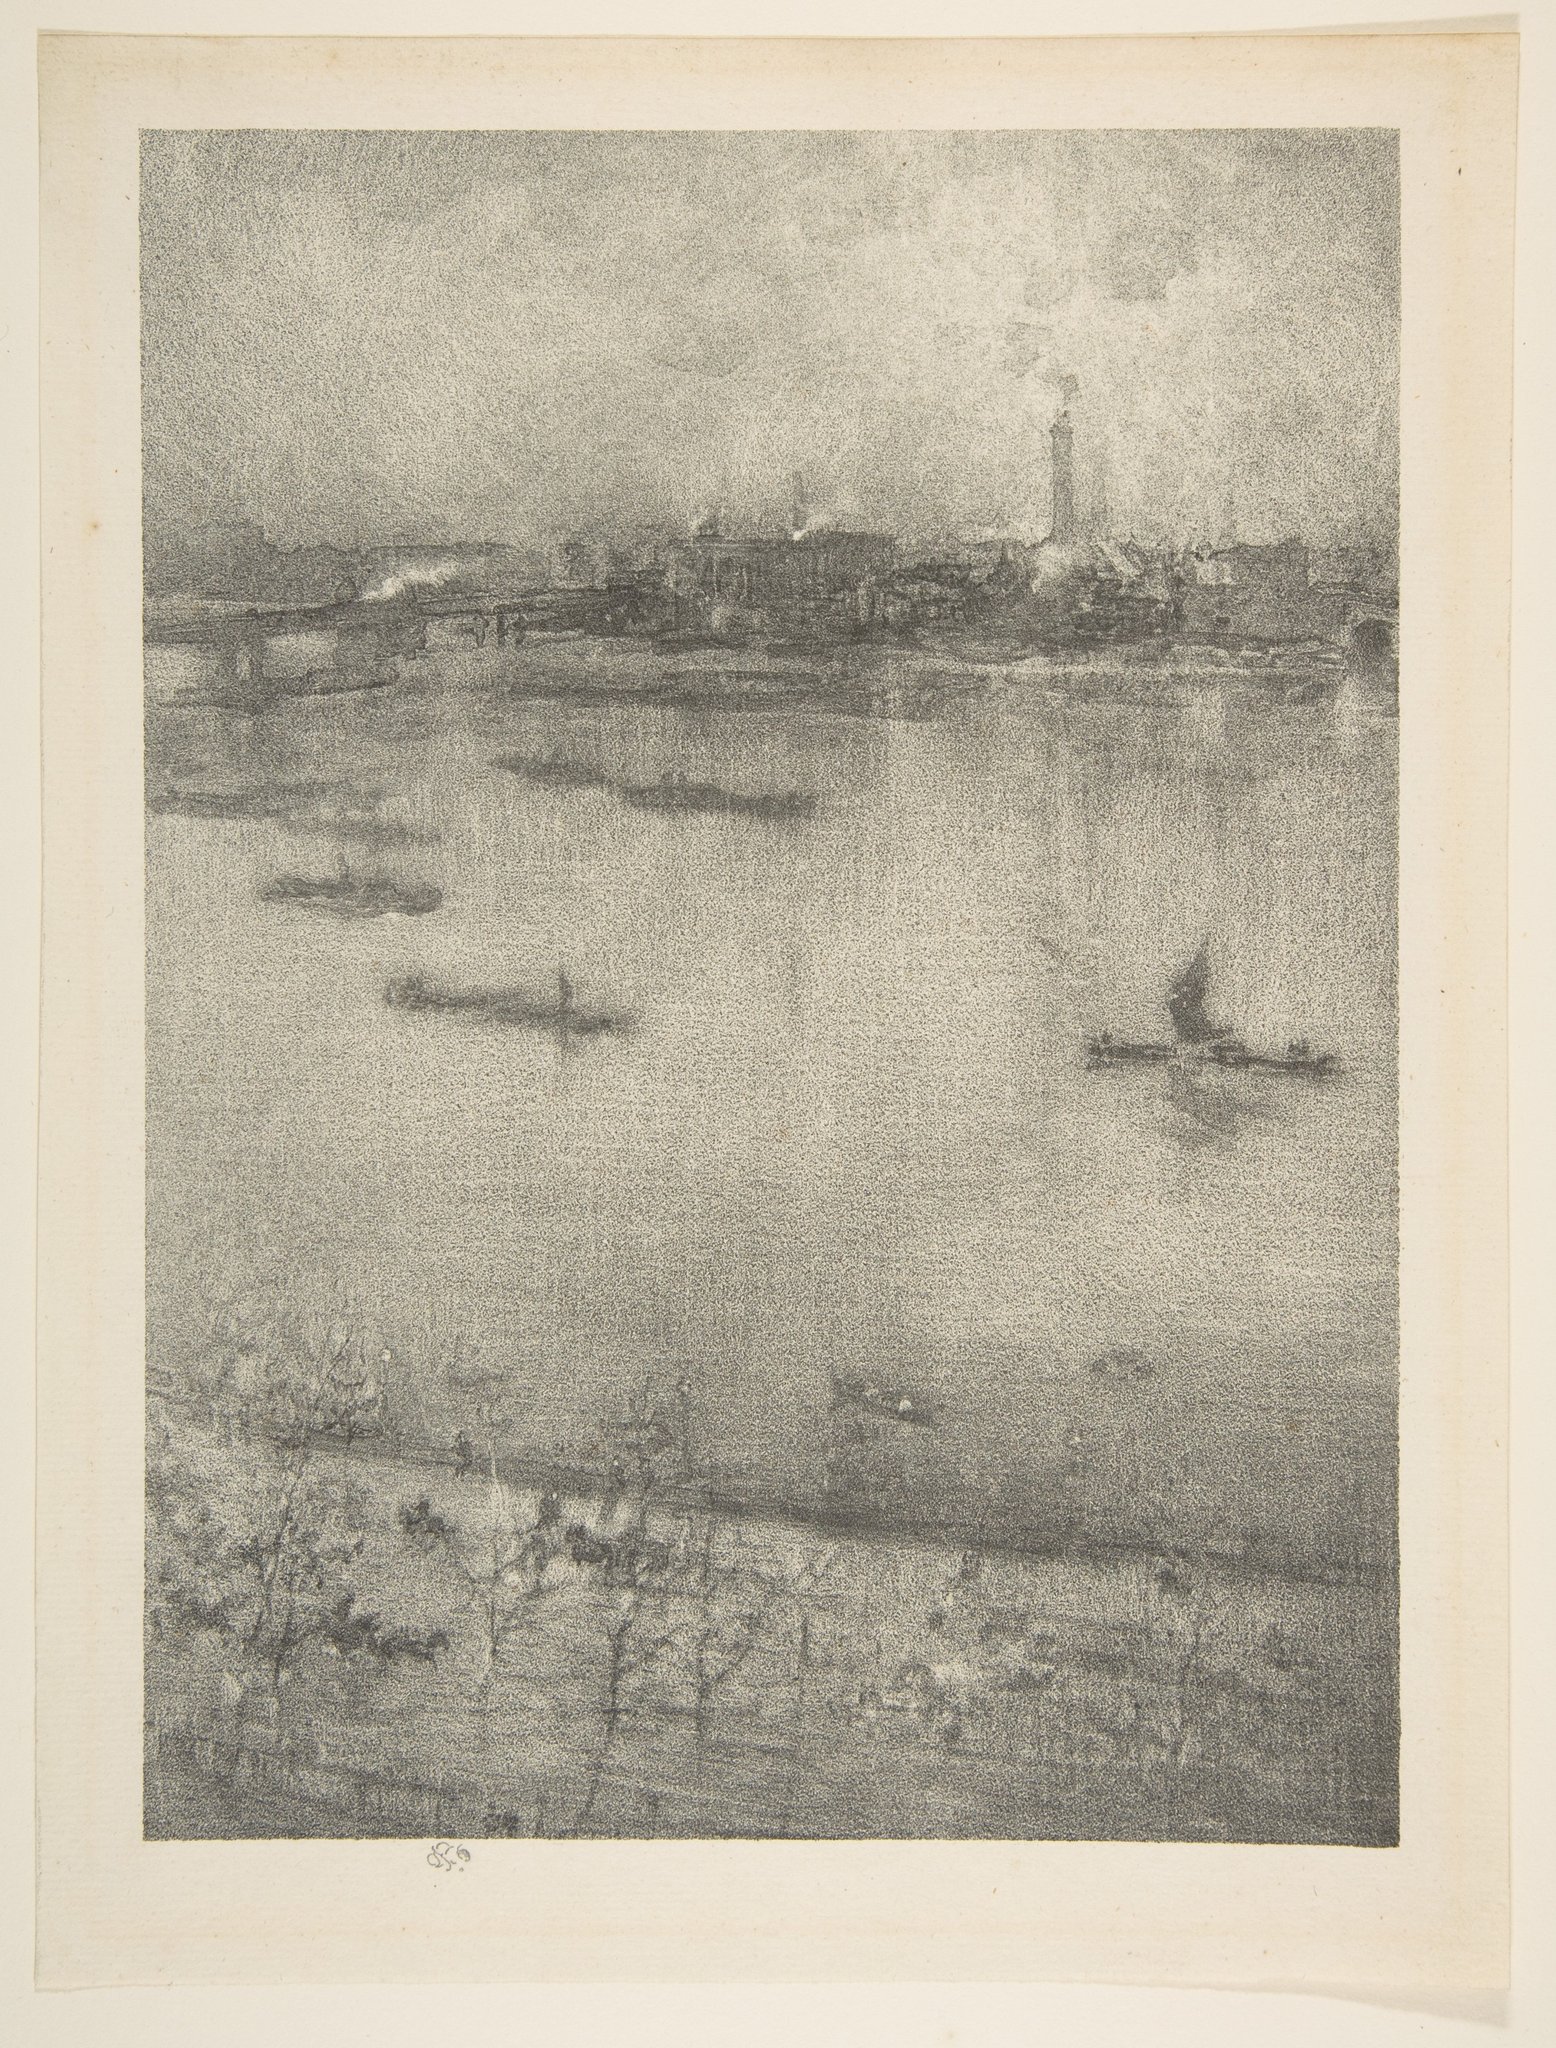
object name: print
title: The Thames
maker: james mcneill whistler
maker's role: artist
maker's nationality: american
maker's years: 1834-1903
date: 1896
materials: ink, paper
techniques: printing, scraping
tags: buildings,rivers